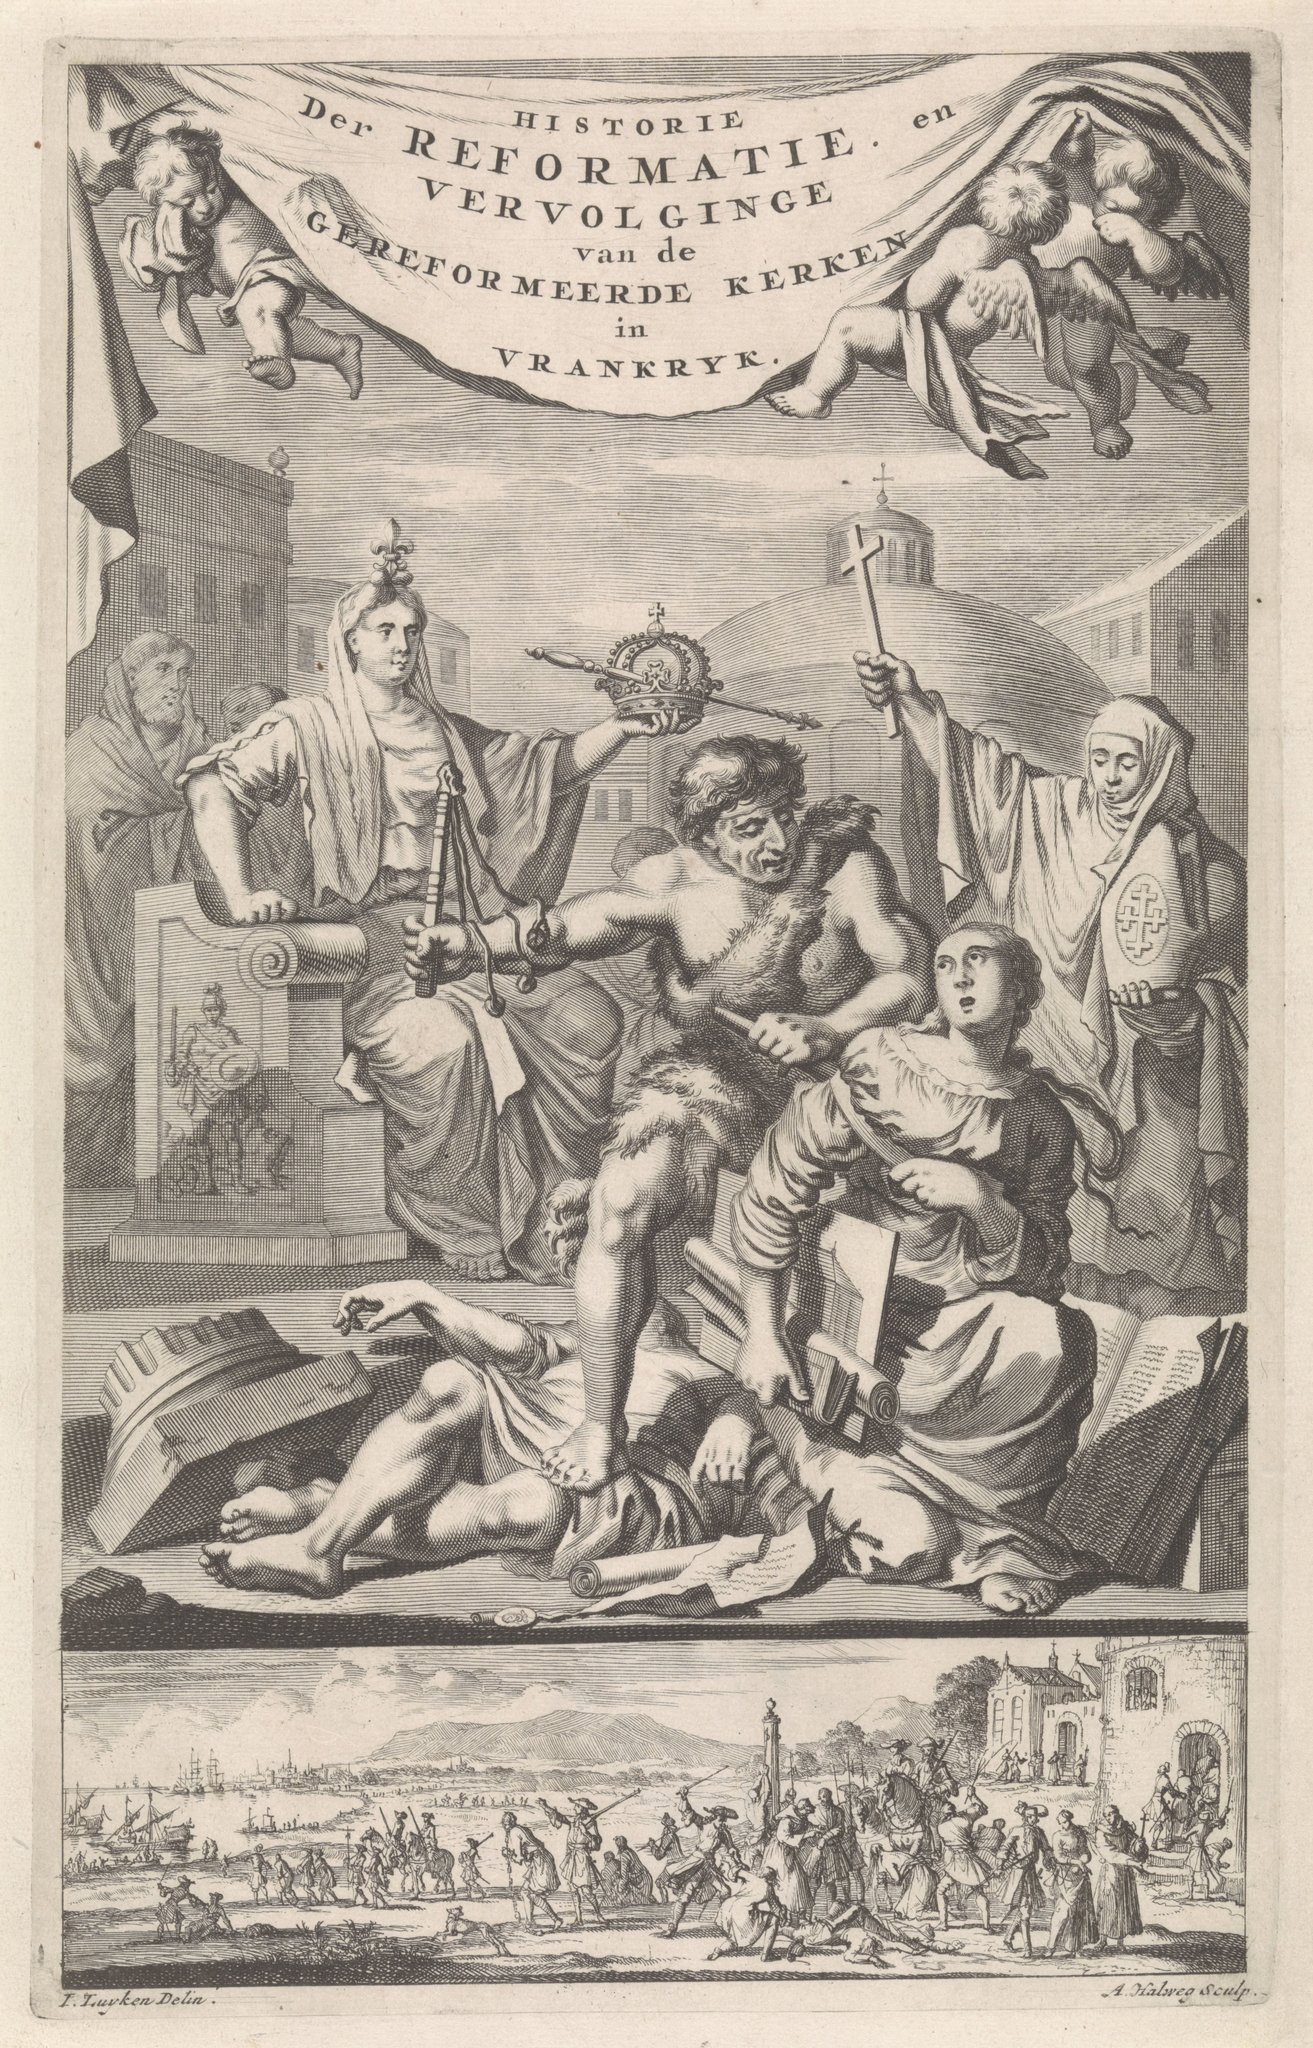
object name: print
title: Titelpagina voor: E. Benoist, Historie der gereformeerde kerken van Vrankryk, 1696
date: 1696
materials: paper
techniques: engraving, etching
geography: amsterdam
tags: personifications of countries, nations, states, districts, etc., persecution of believers, the roman catholic church vs. protestantism; (reformation and counter reformation)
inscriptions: collector's mark: Lugt 2228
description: Twee voorstellingen van één plaat. Boven: de personificatie van de Franse Hervormde Kerk, de Hugenoten, wordt aangevallen door een wilde man met een gesel. Dit vindt plaats onder goedkeuring door personificaties van het Franse koningschap (Gallia) en de Franse Katholieke Kerk. Hieronder een smalle voorstelling van de vervolging en verdrijving van de Hugenoten.